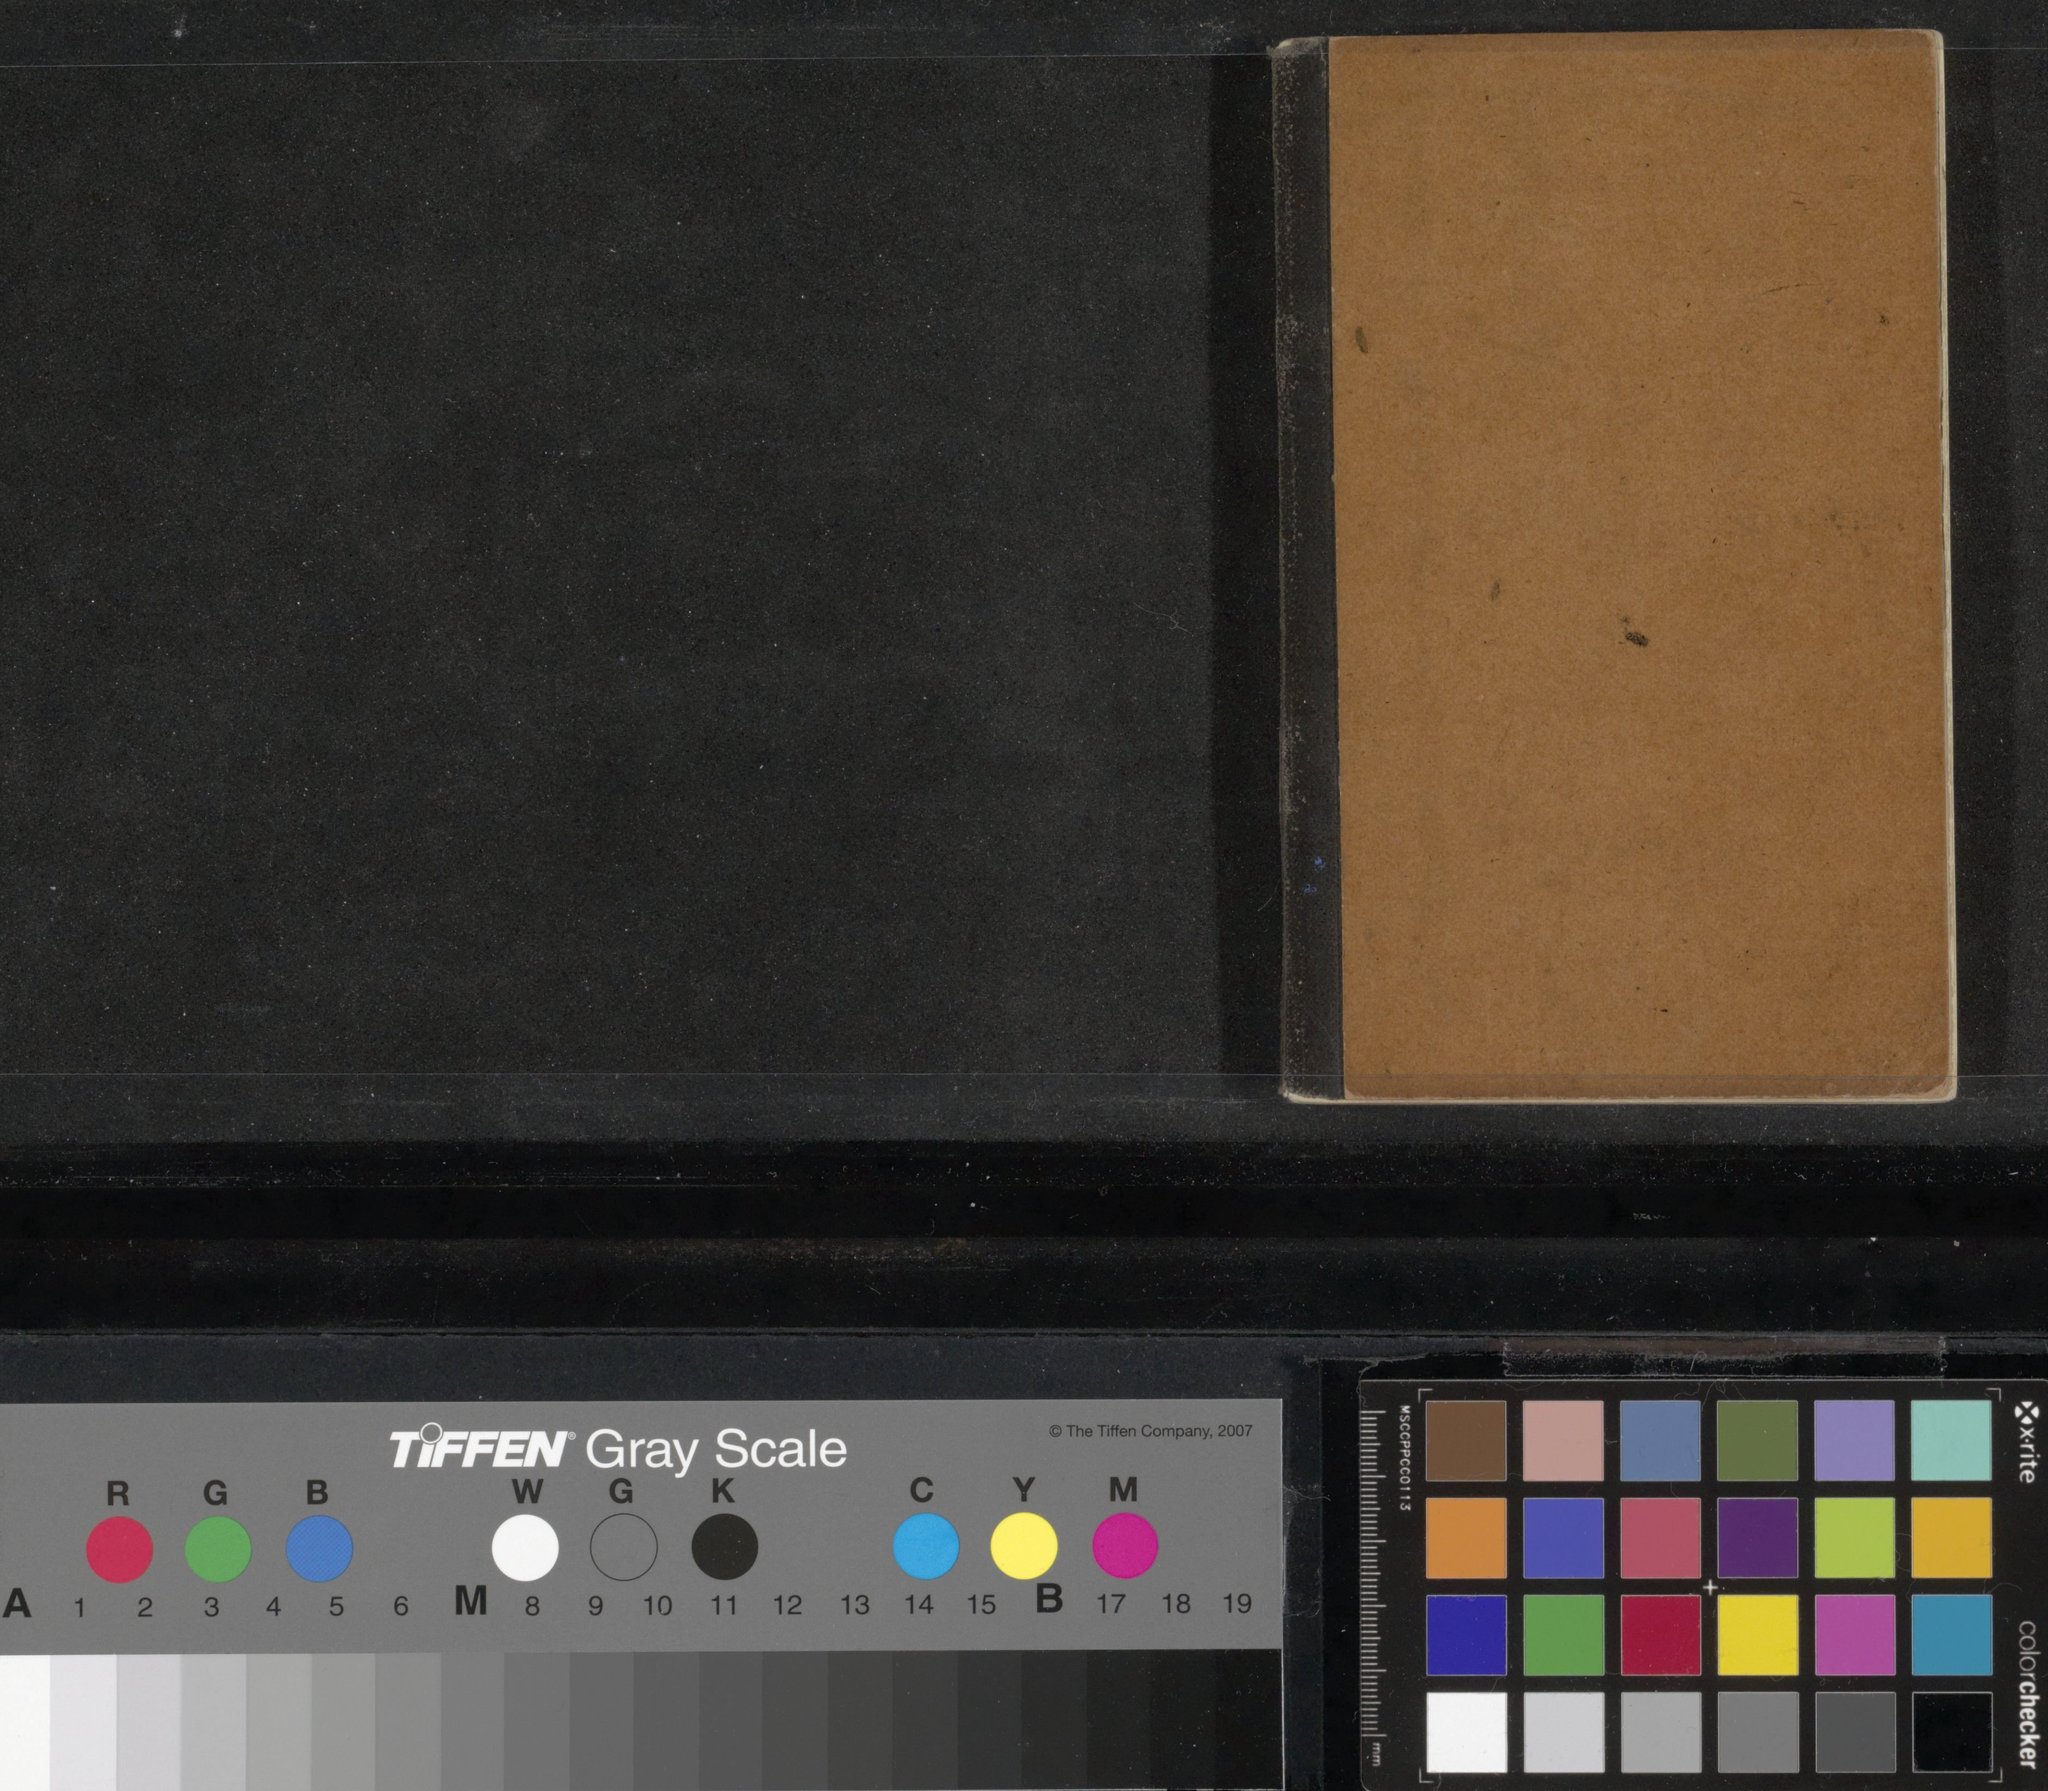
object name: sketchbook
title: Schetsboek met 53 bladen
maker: marius bauer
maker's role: draughtsman, print maker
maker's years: 1867-1932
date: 1896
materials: cardboard, chalk, linen, paper, pencil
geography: turkey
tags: asiatic races and peoples, city-view, and landscape with man-made constructions, temple, shrine ~ islam, mohammedanism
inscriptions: collector's mark: Lugt 2228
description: Schetsboek bestaande uit 53 bladen gemaakt tijdens een reis door Turkije en Constantinopel, met voornamelijk studies van figuren in oosterse kleding, het interieur en exterieur van verschillende moskeeën en enkele landschappen en stadsgezichten.